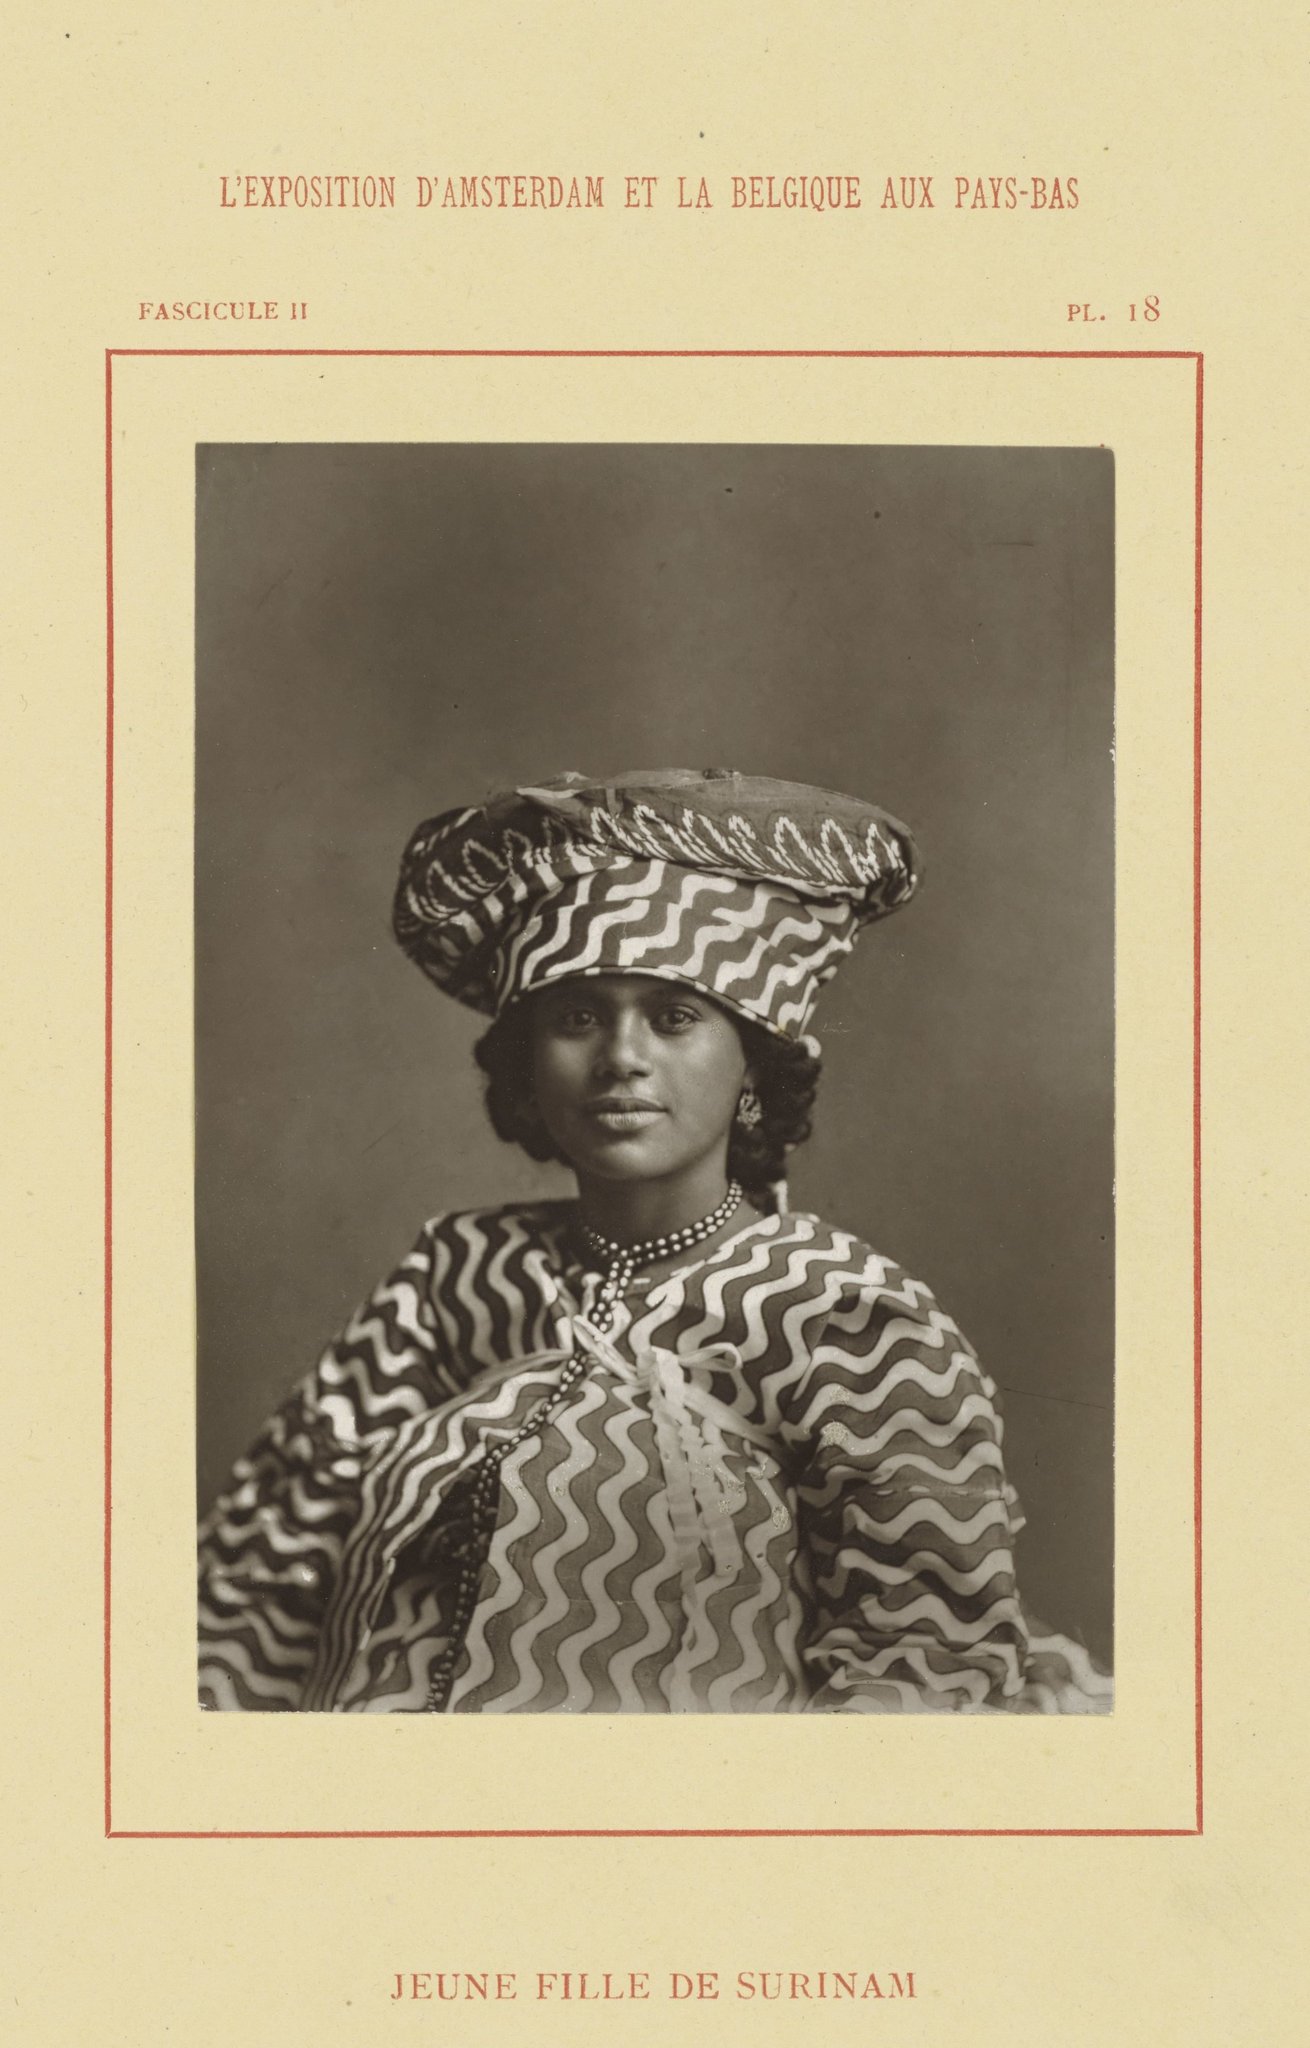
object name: photograph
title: Jeune Fille de Surinam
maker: théophile fumière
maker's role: publisher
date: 1883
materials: cardboard, paper, photographic support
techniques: woodburytype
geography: amsterdam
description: Fascicule II pl. 18 uit L'exposition d'Amsterdam et la Belgique aux Pays-Bas, 1883.